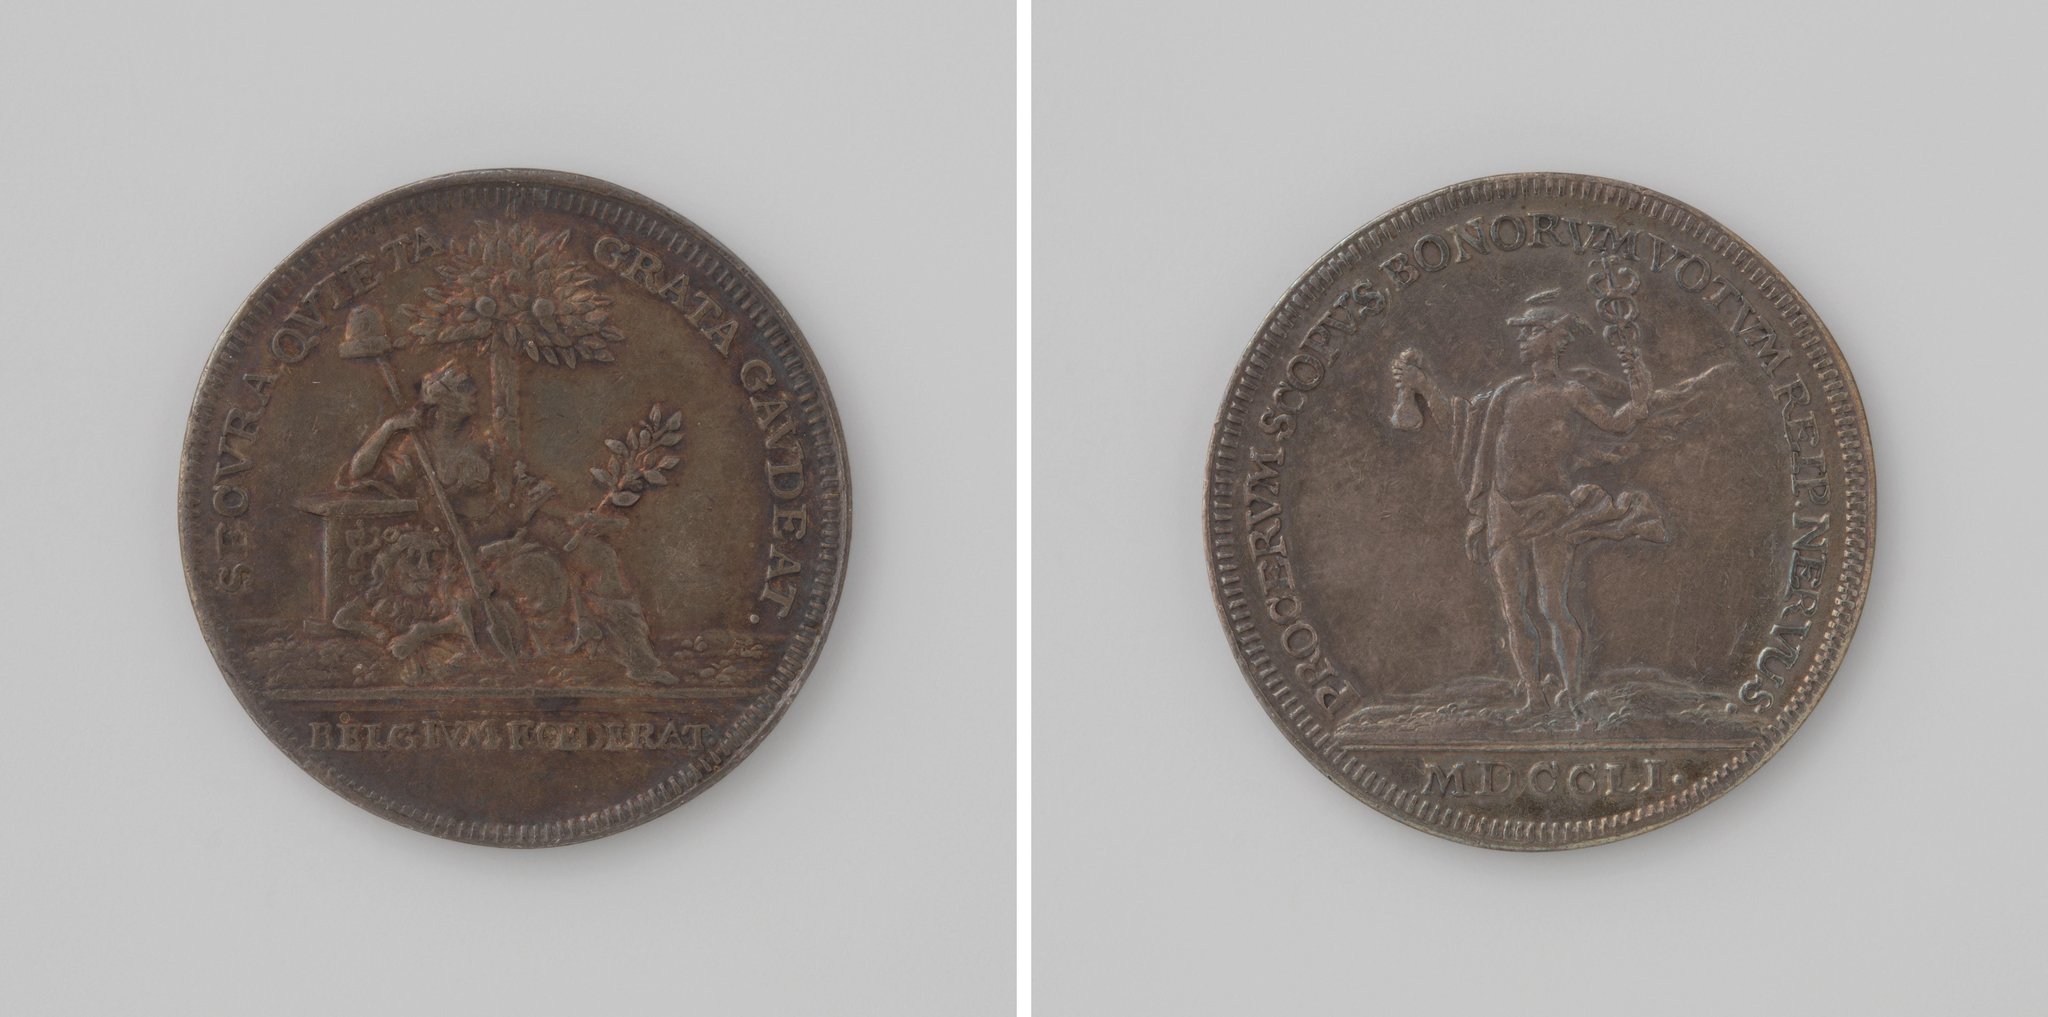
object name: new year medal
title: Aanvang van het jaar 1751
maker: johan george holtzhey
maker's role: mintmaster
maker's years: 1726-1808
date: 1751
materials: silver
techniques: striking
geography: amsterdam